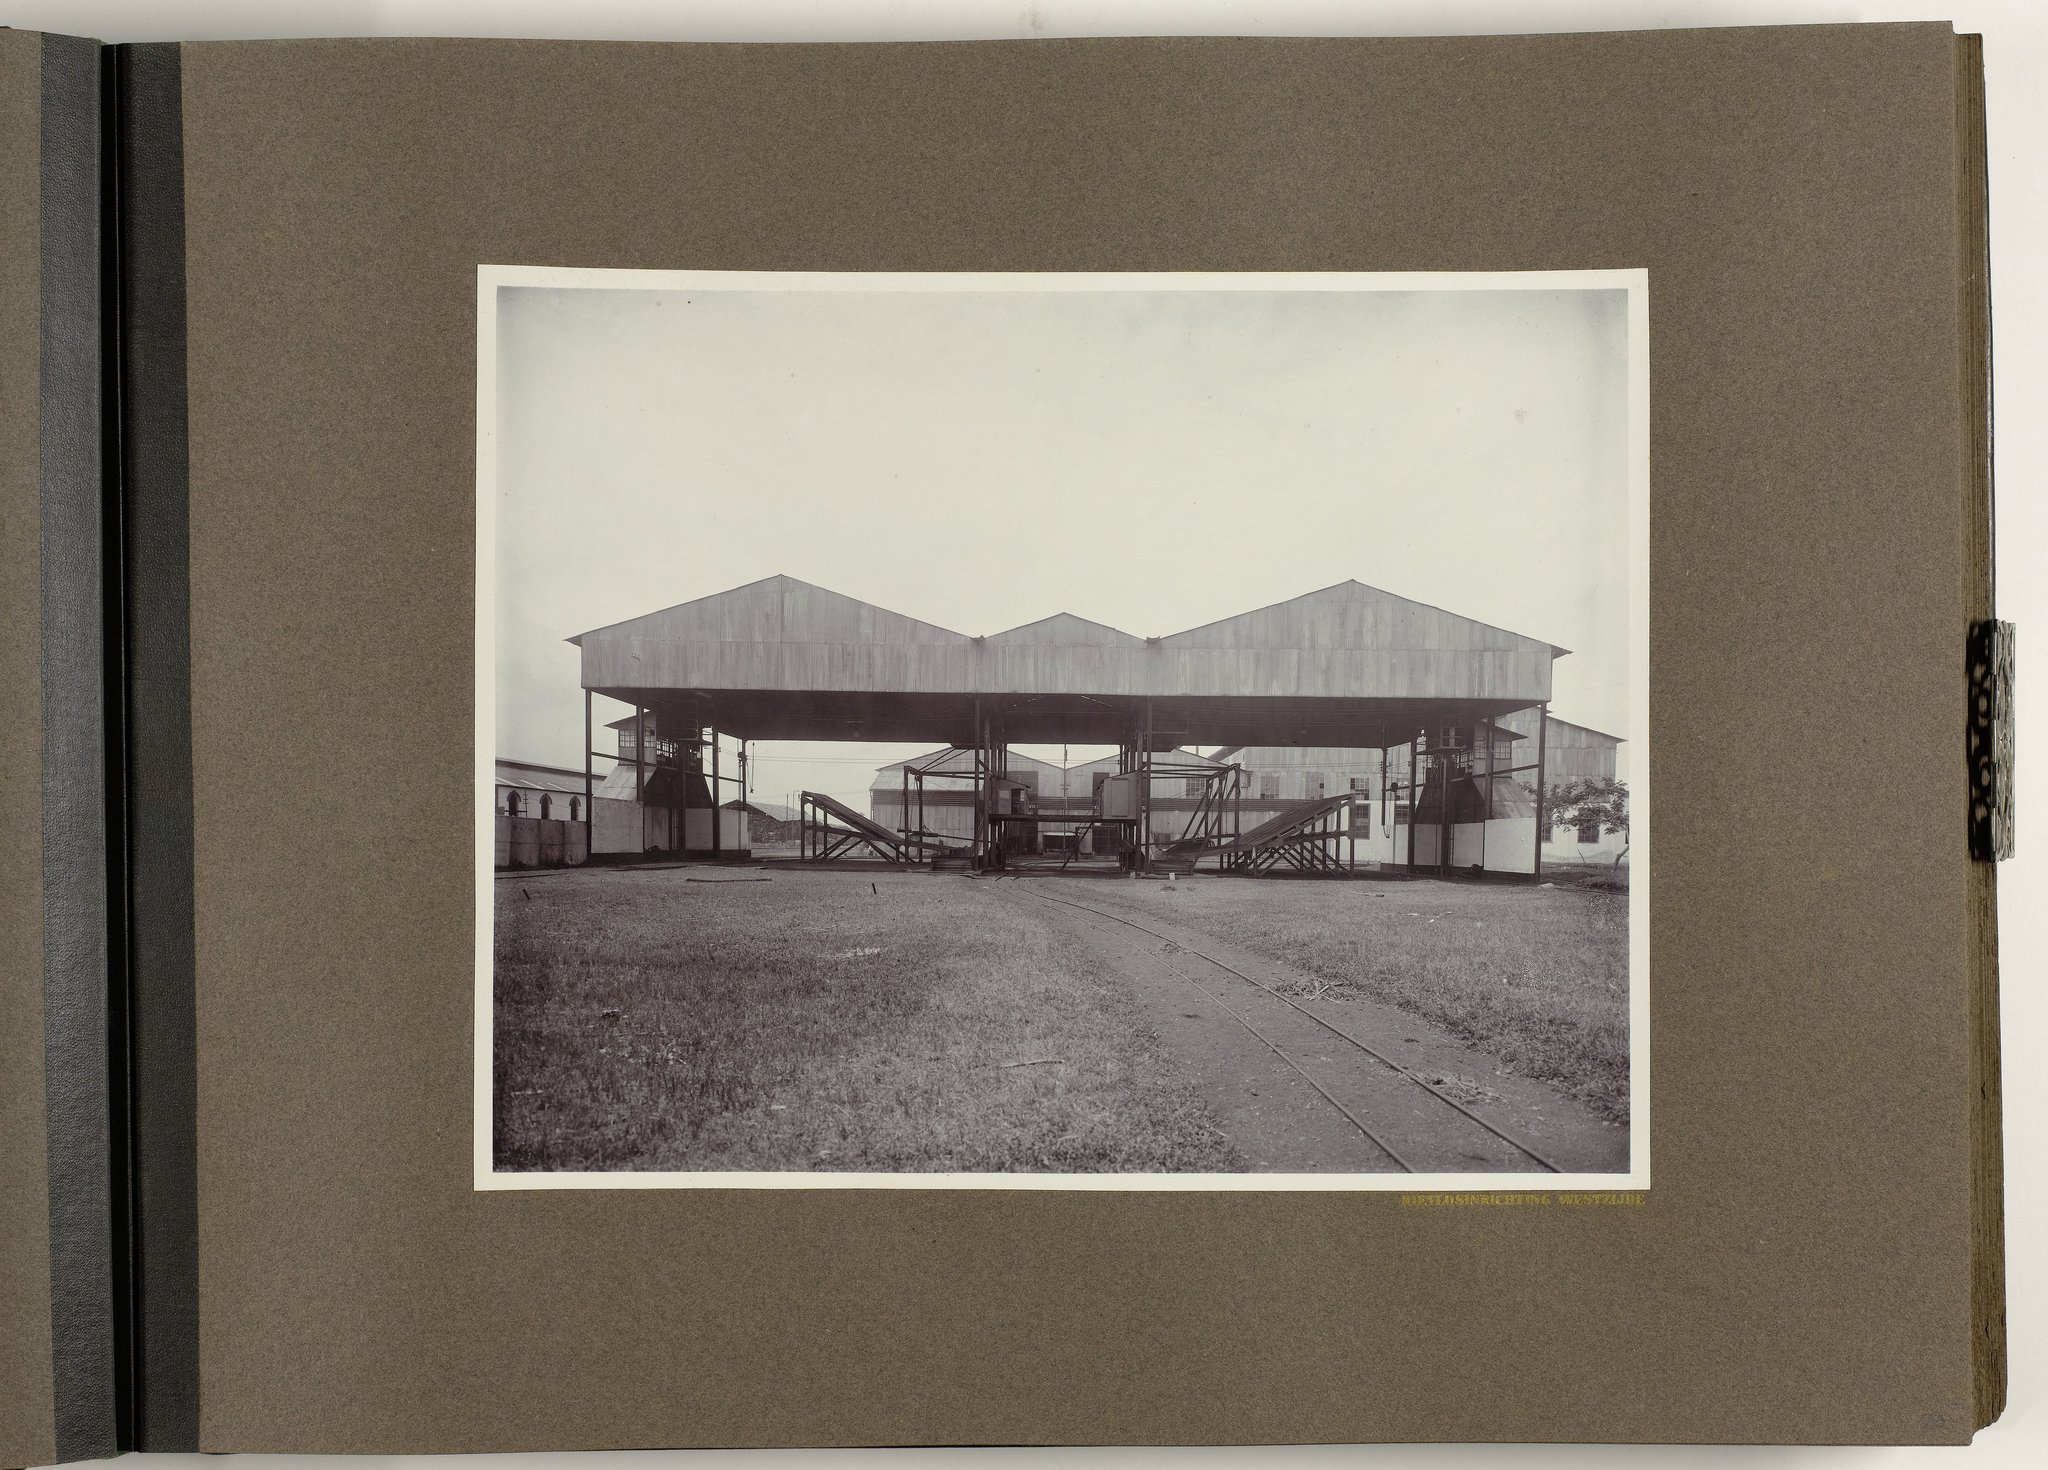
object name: photograph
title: Rietlosinrichting westzijde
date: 1917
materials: photographic support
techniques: gelatin silver print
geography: jatiroto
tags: colonial system, (non-fruit) products of plants or trees: sugarcane, exterior of industrial structures, factories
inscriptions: inscription: ‘RIETLOSINRICHTING WESTZIJDE’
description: Inrichting voor het lossen van treinwagons met suikerriet. Onderdeel van het fotoalbum aangeboden aan F.J. Wirix door het personeel van de Suikeronderneming Djatiroto in 1917.